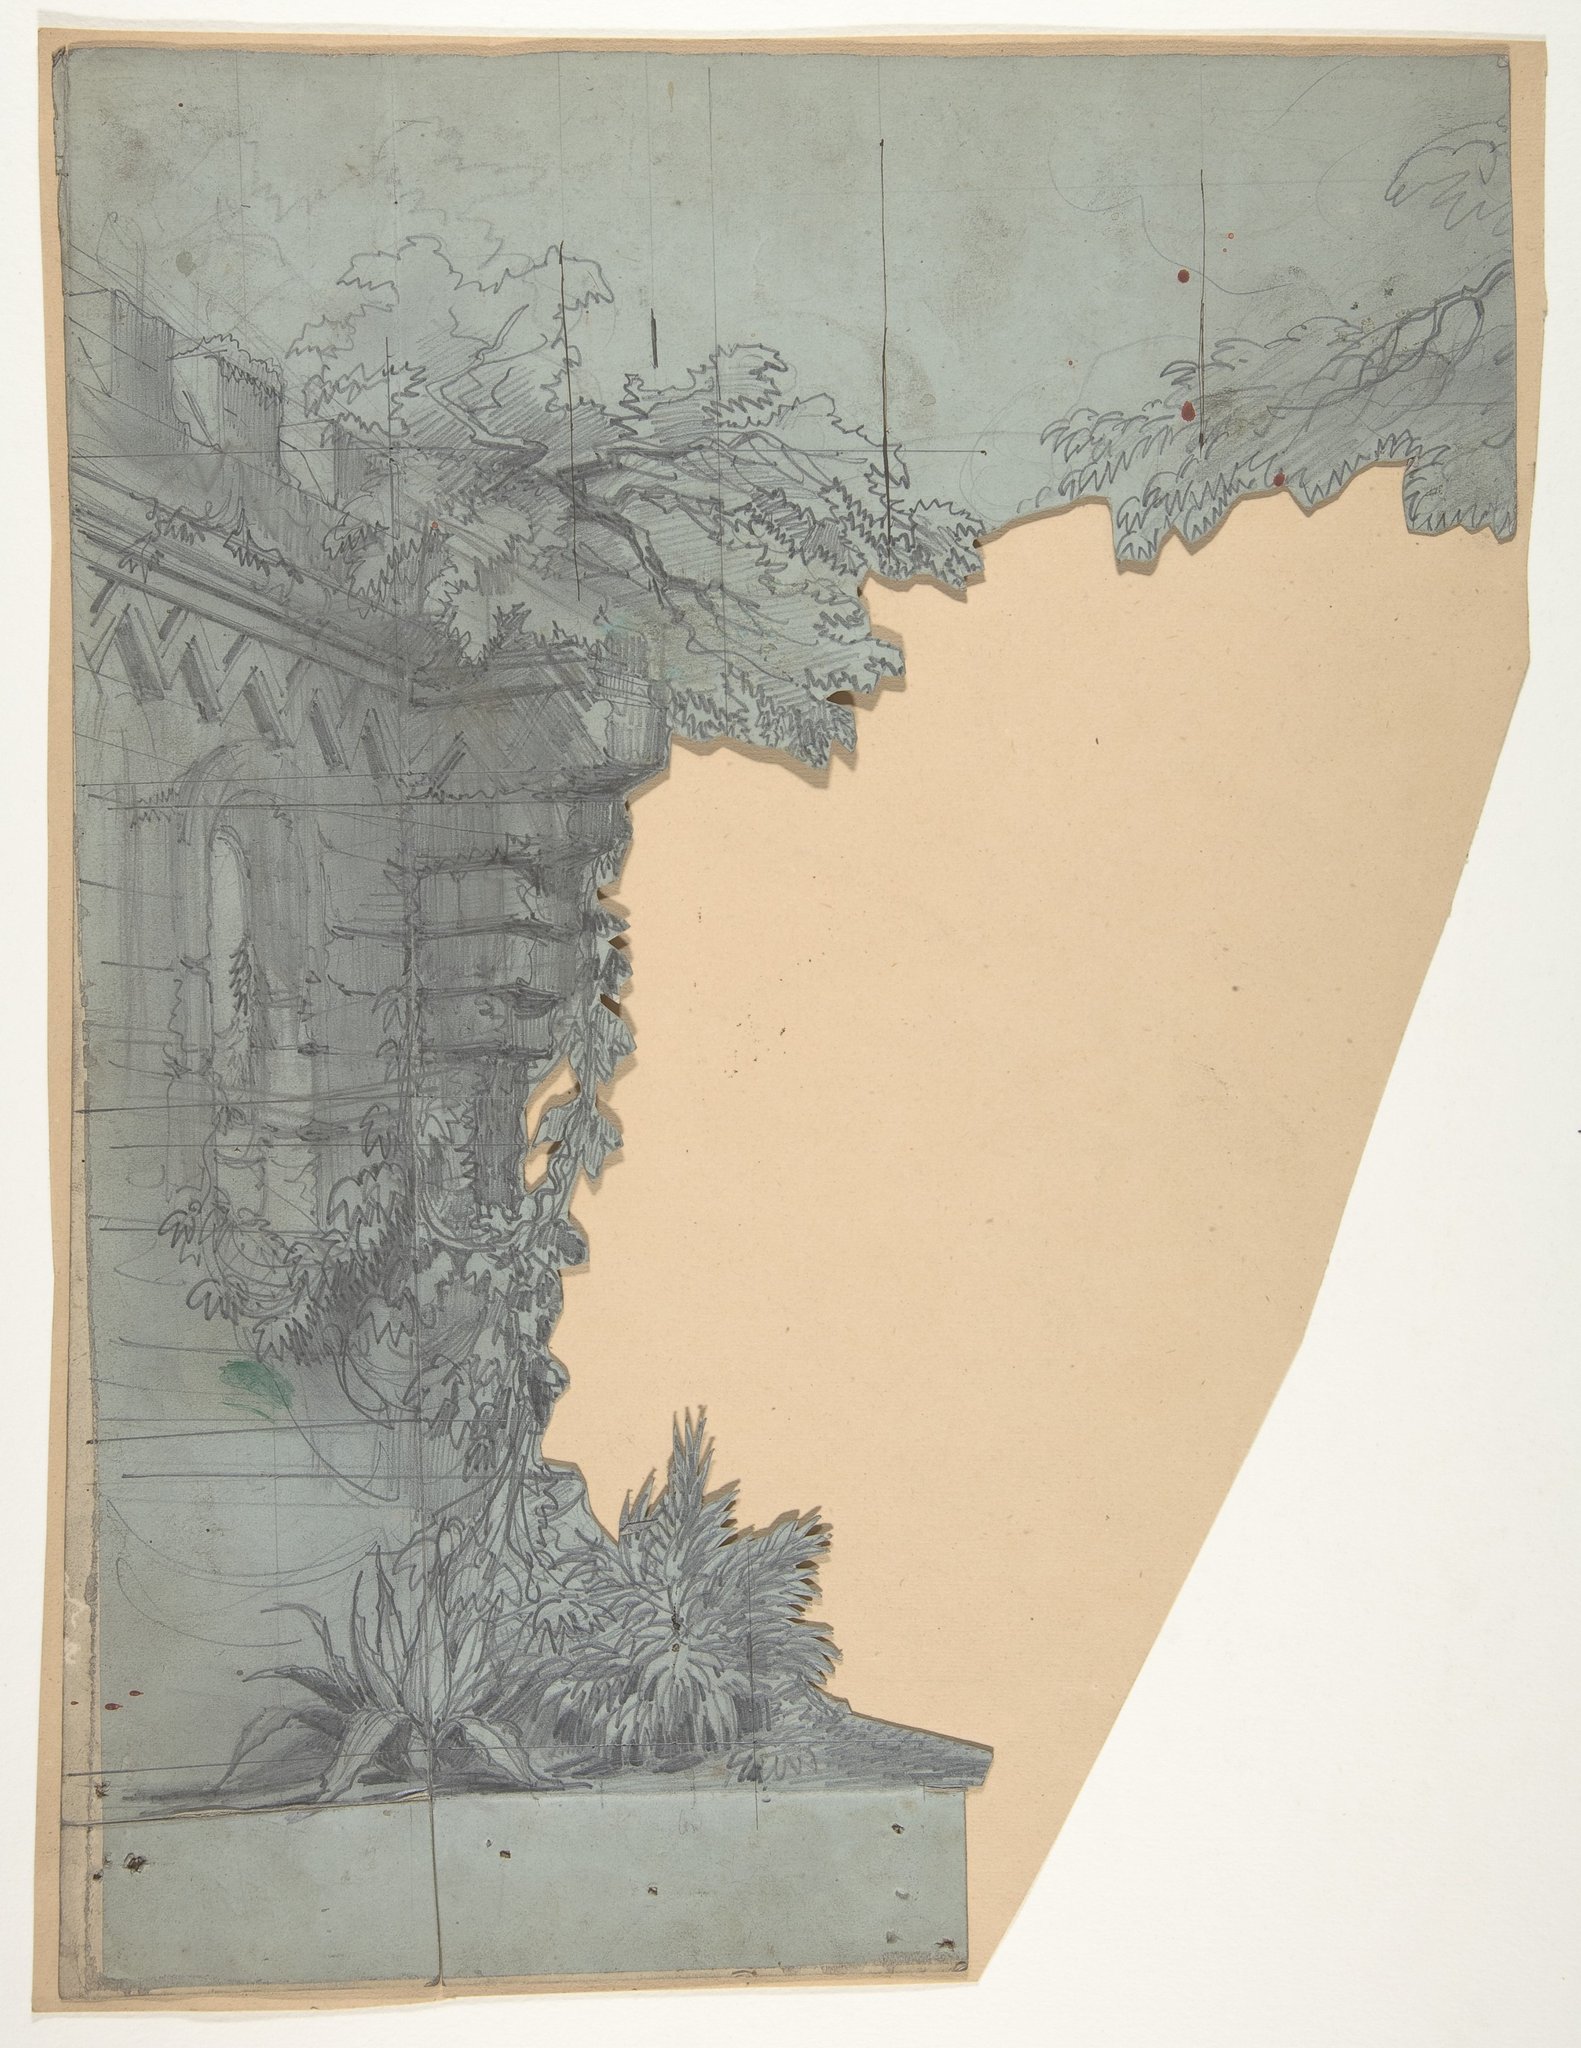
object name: drawing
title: Design for a Stage Set at the Opéra, Paris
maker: eugène cicéri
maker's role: artist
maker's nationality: french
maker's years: 1813-1890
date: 1840-1890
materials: graphite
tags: stage design